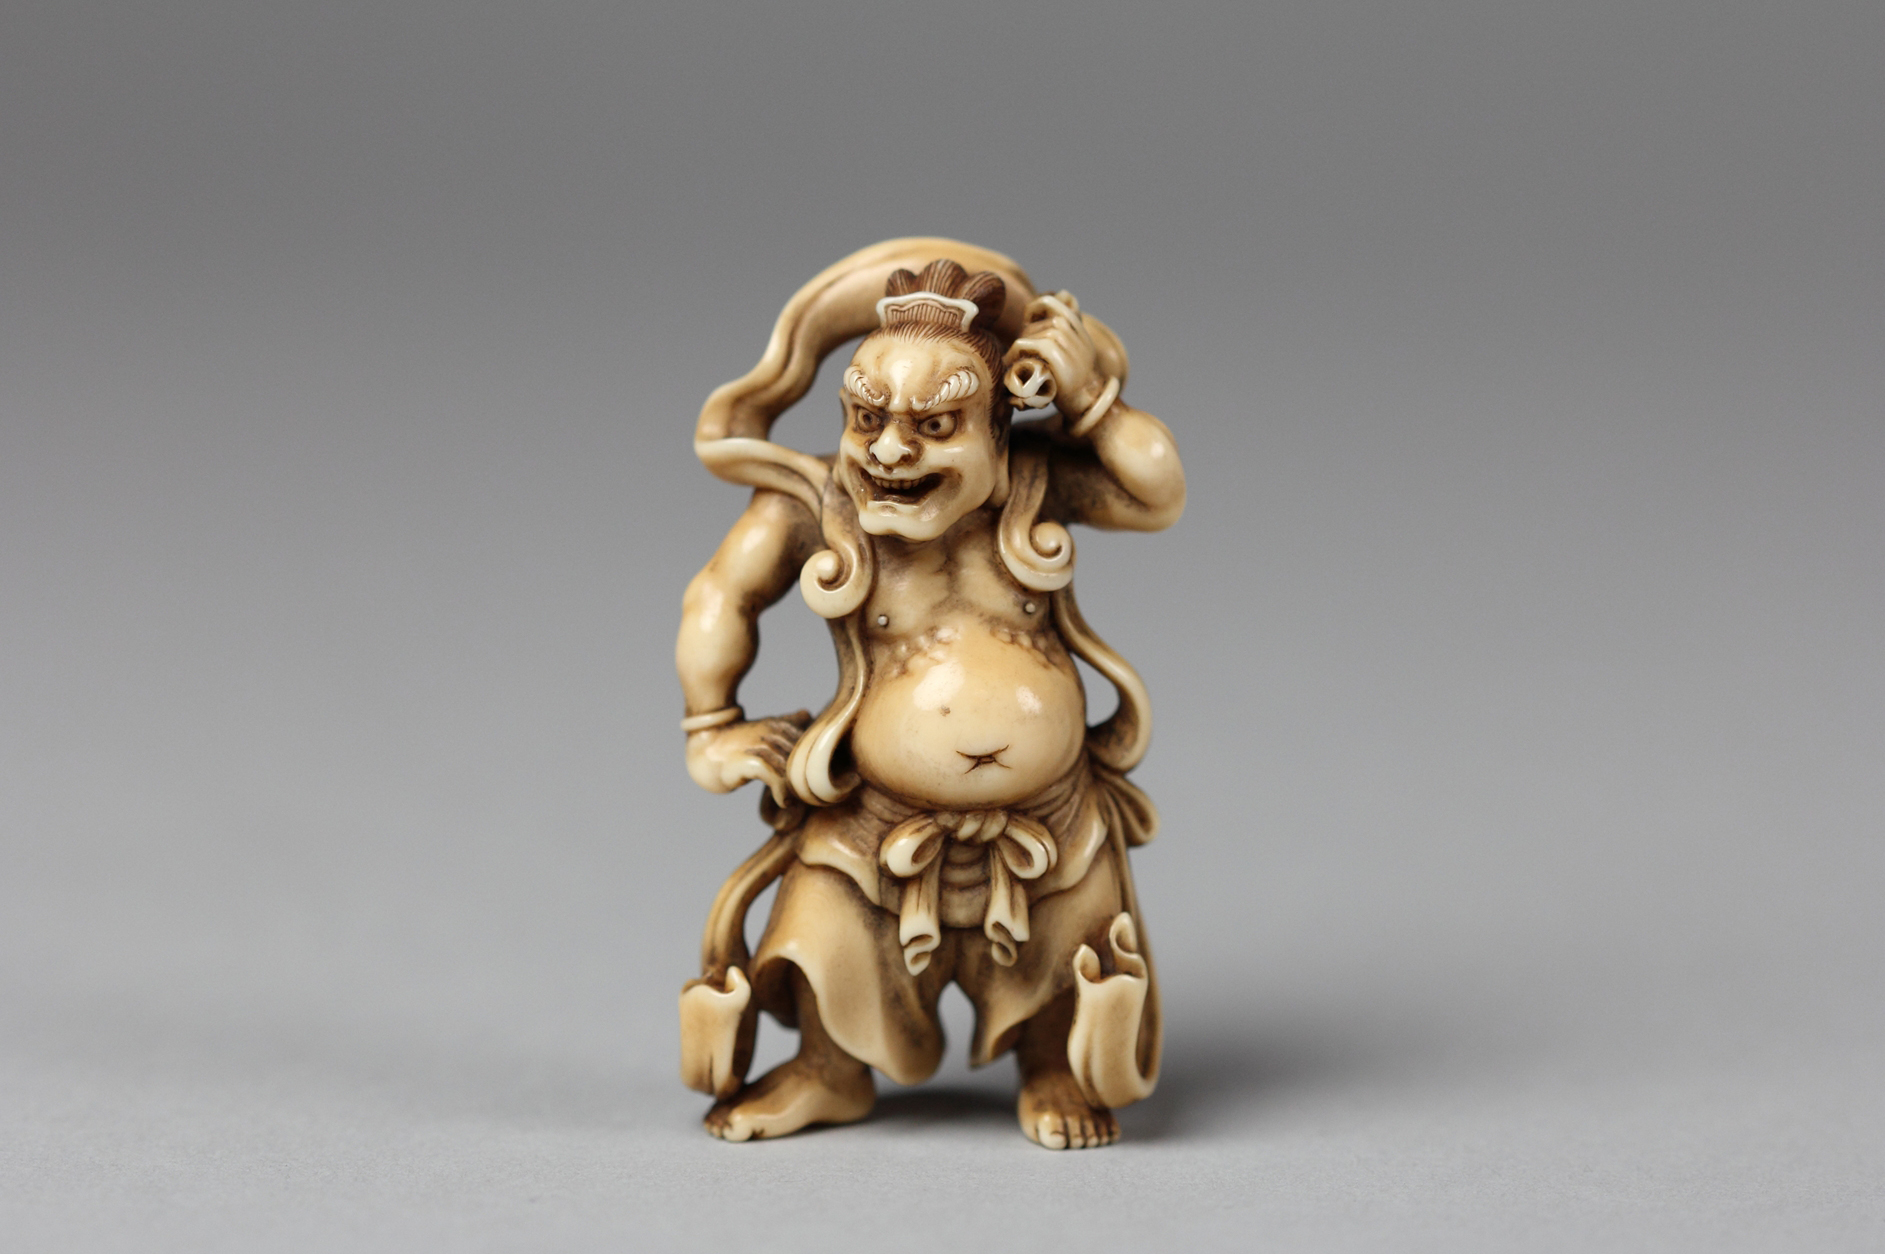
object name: netsuke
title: Niō Guardian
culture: japanese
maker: josō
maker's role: artist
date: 1851-1900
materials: ivory